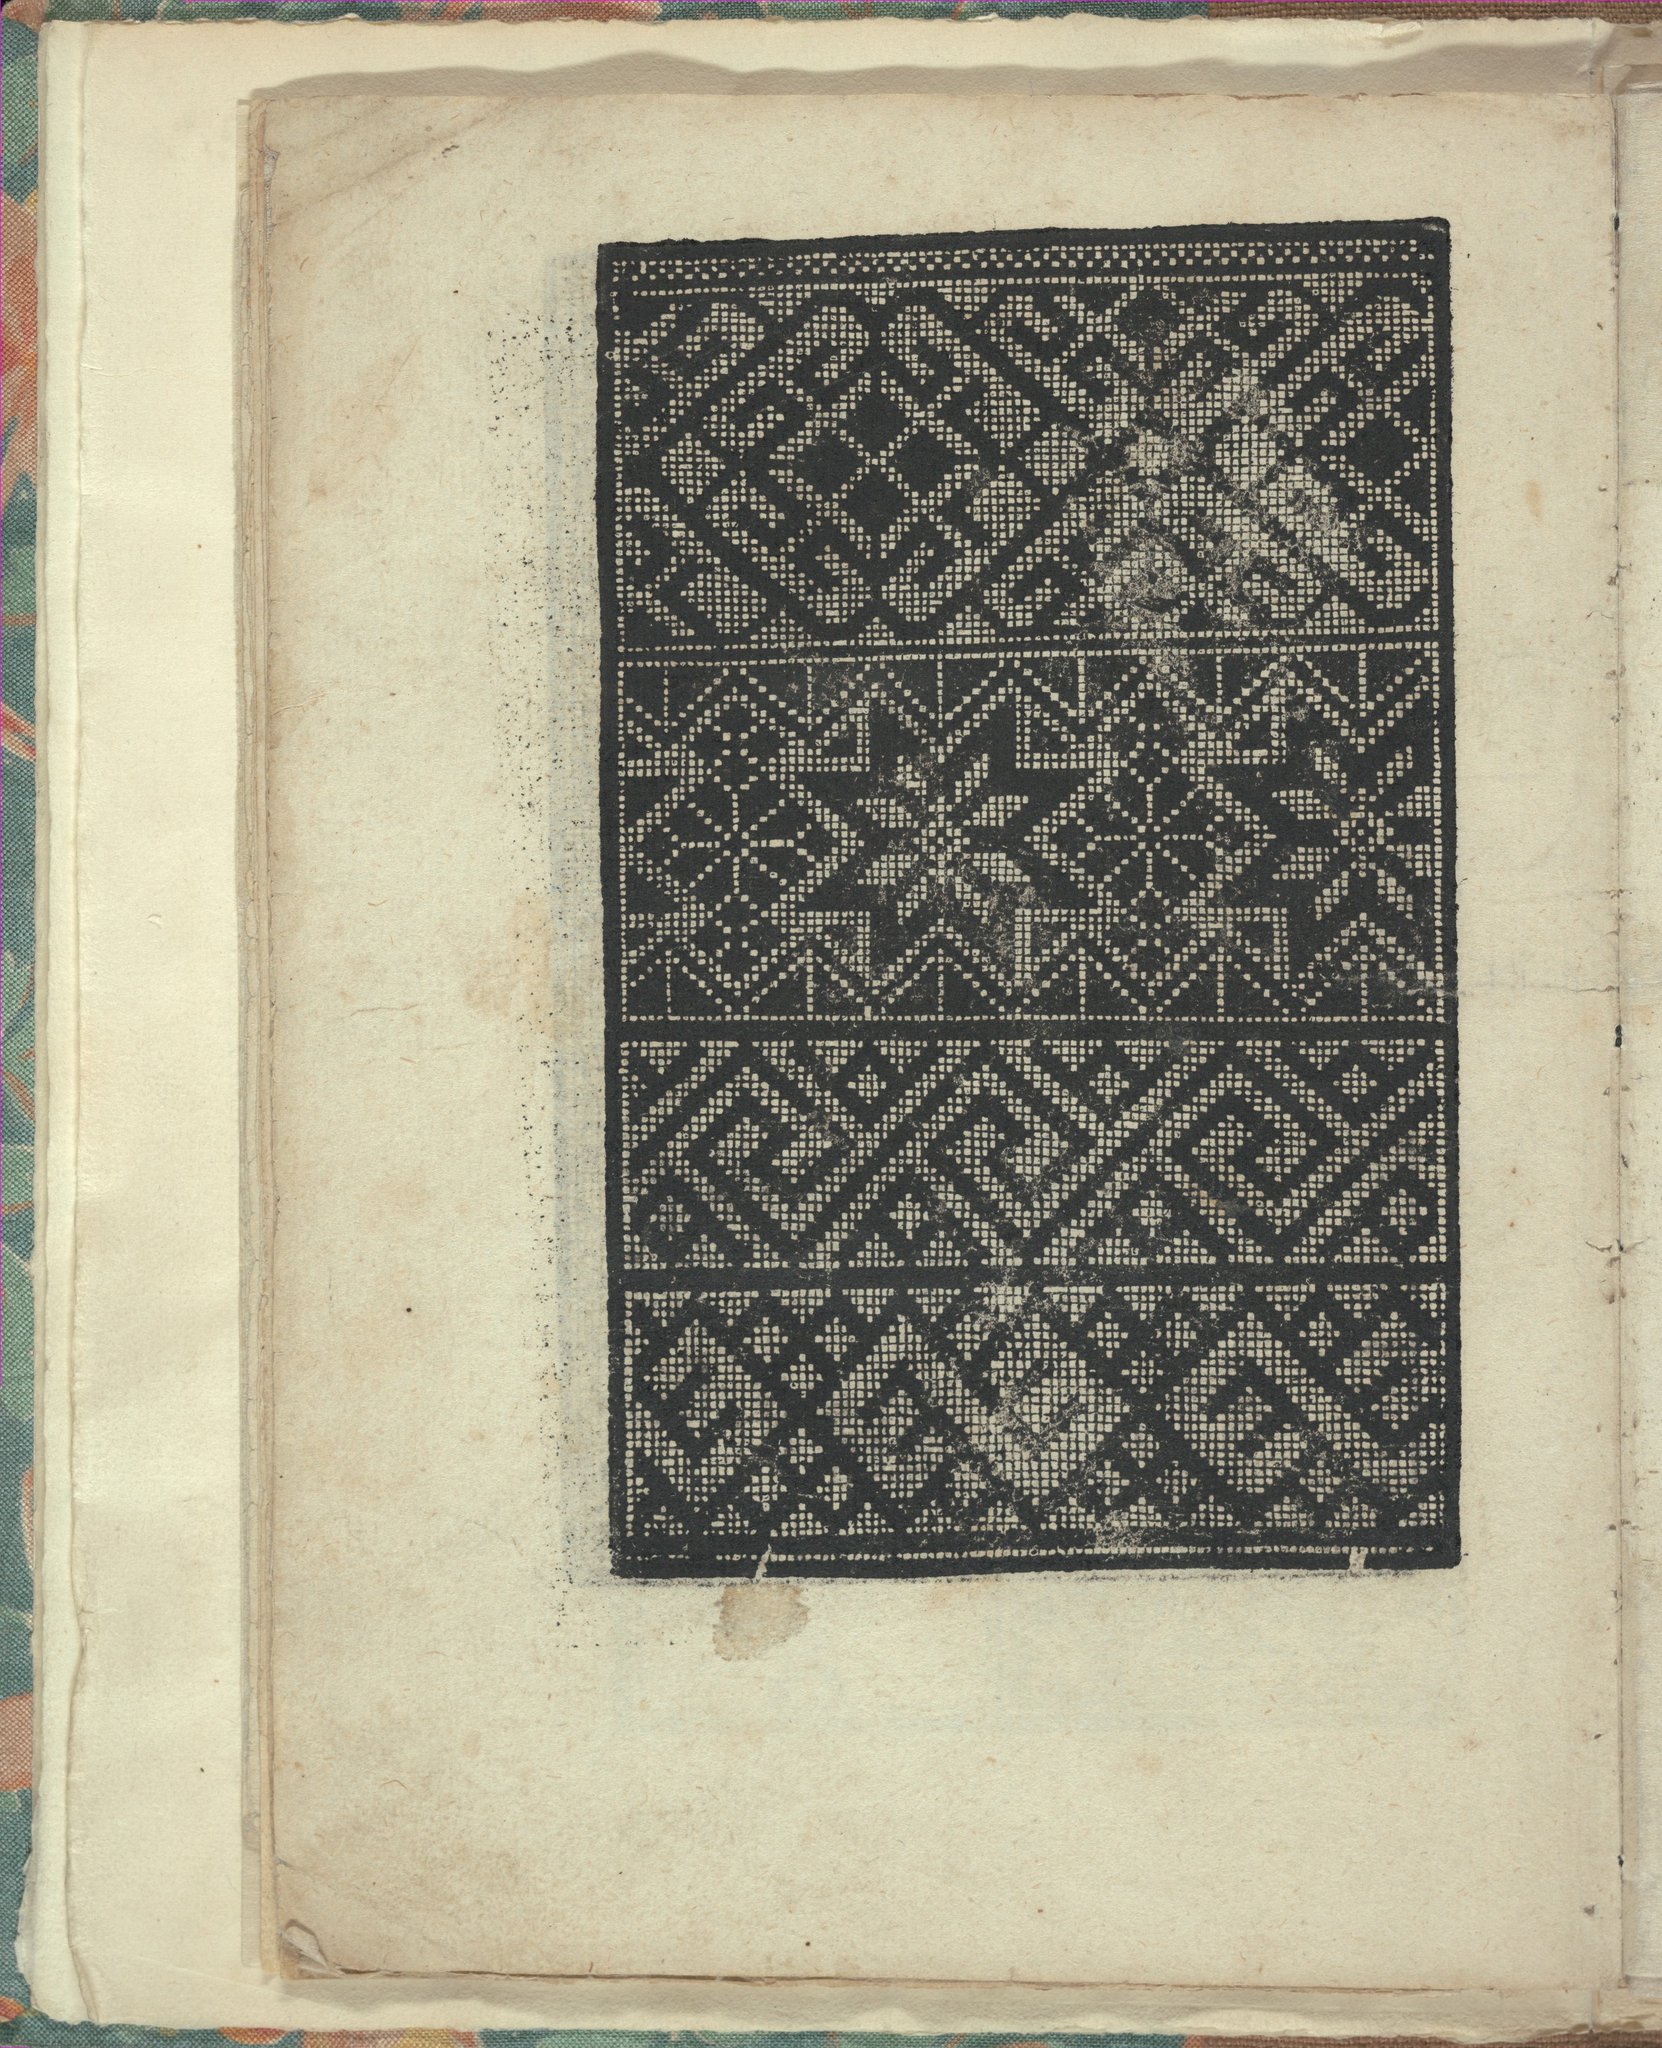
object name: book print ornament architecture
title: Opera Nova Universali intitulata Corona di racammi, page 13 (verso)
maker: giovanni andrea vavassore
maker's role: publisher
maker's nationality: italian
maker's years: 1530-1573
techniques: woodcut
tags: ornament